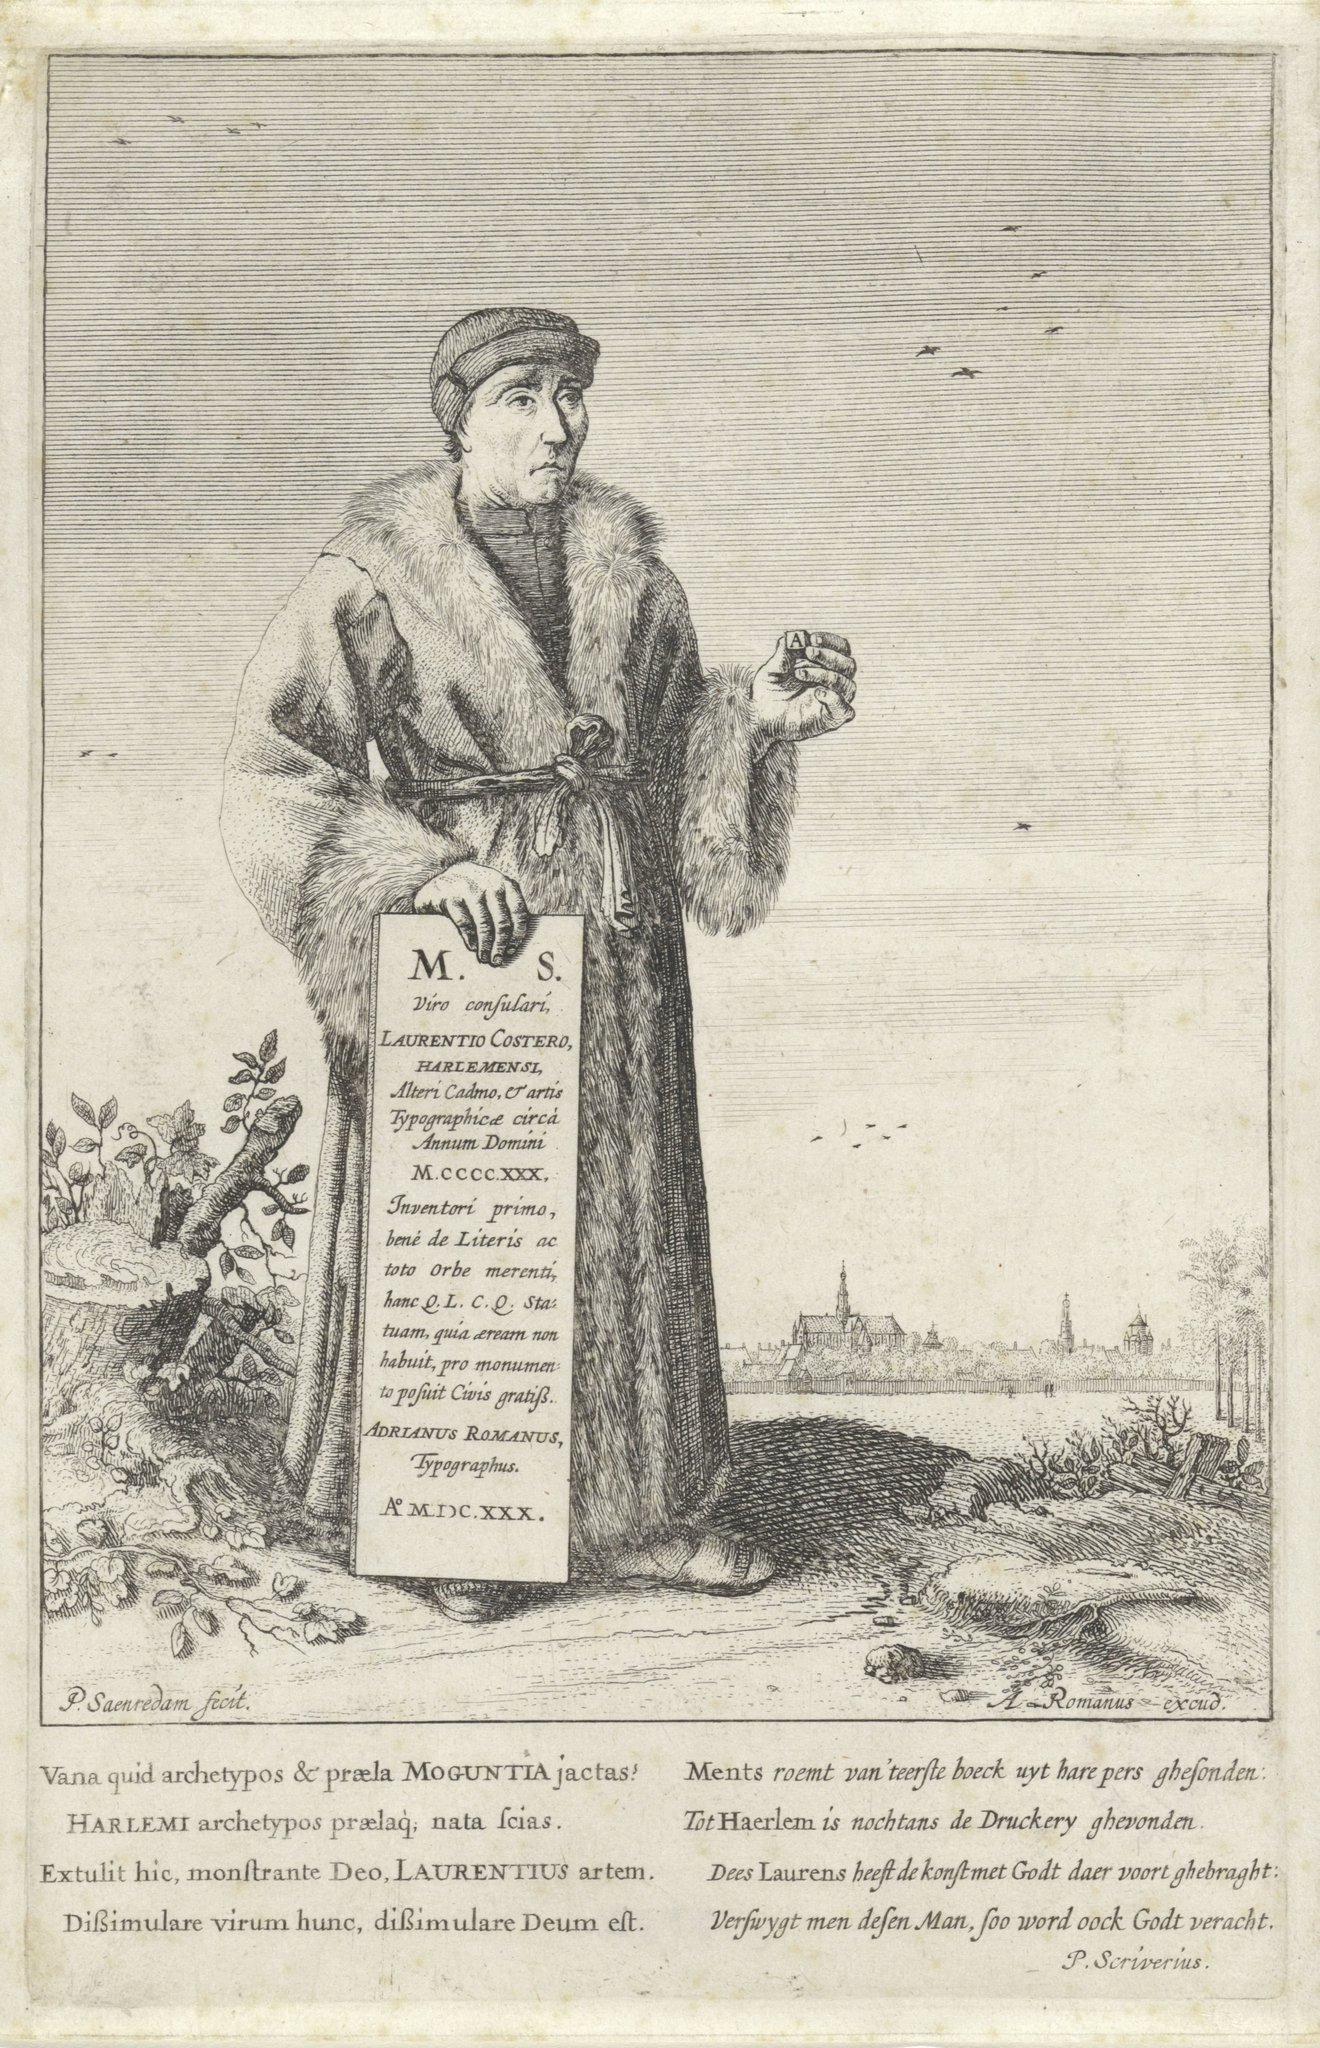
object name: print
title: Portret van Laurens Jansz. Coster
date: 1630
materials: paper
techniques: engraving, etching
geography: haarlem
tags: haarlem, head-gear: hat (+ men's clothes)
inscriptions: collector's mark: Lugt 240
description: In een veld voor de stad Haarlem staat Laurens Jansz. Coster, een van de uitvinders van de boekdrukkunst. Hij draagt een muts en een bontkraag, en heeft in zijn ene hand een plaat met zijn titels en in de andere een drukletter. Op de achtergrond de contouren van Haarlem, met de Sint-Bavokerk.